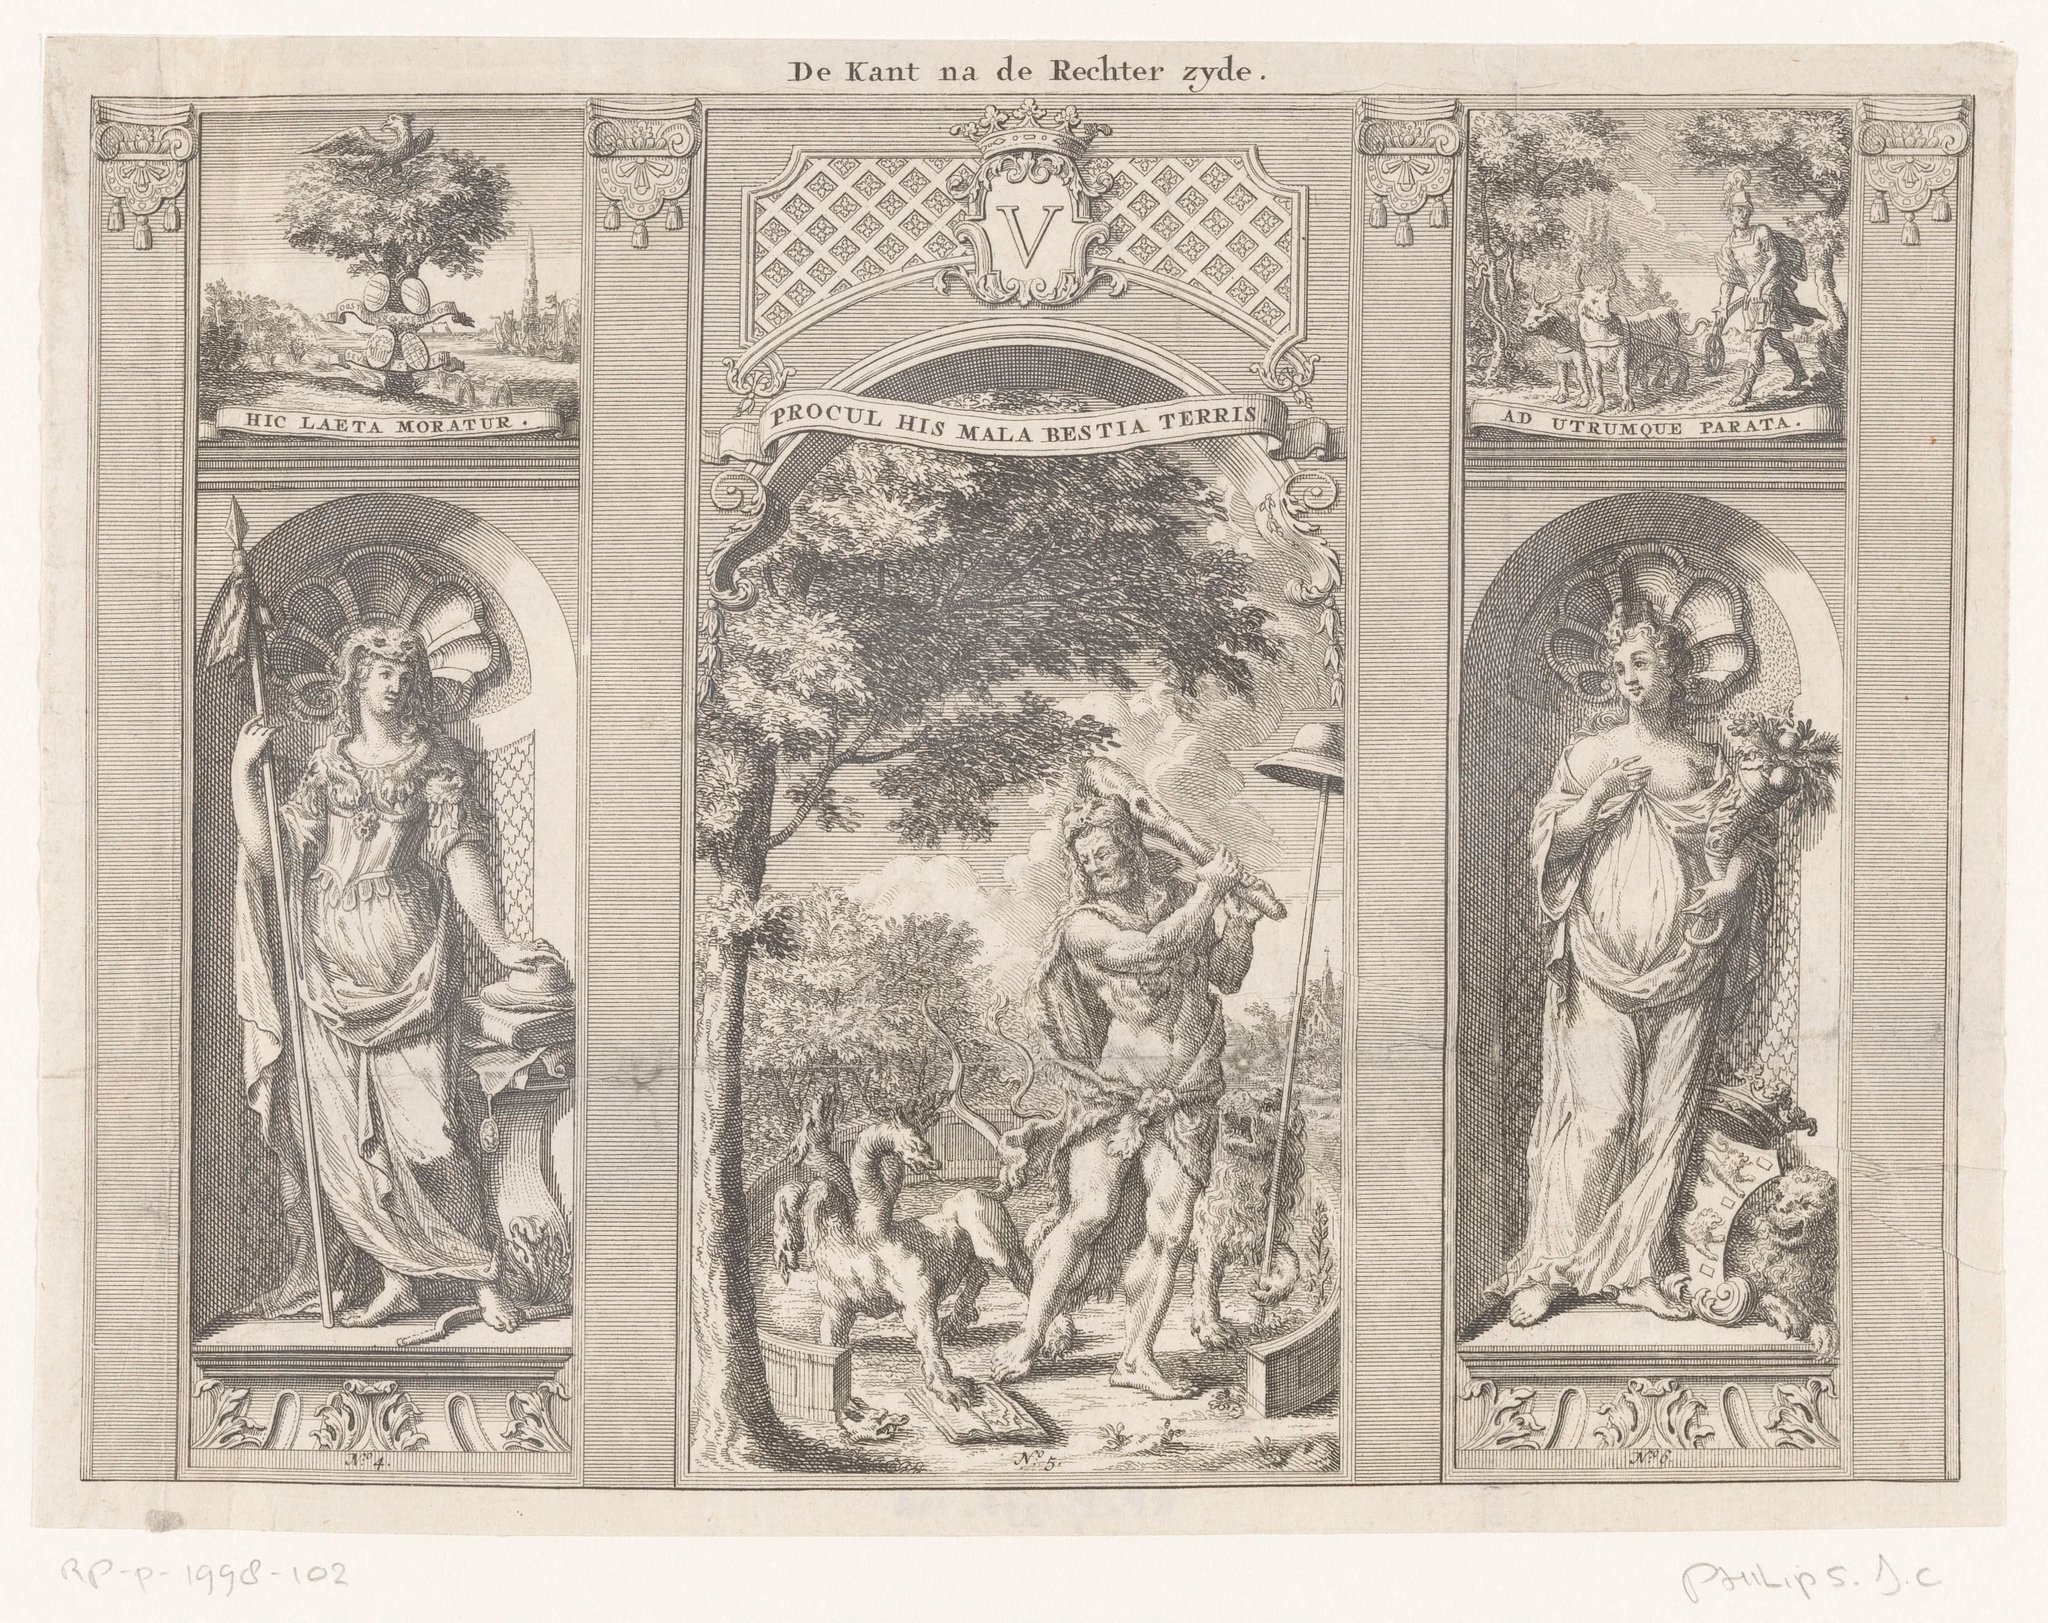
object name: ornament print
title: Personificaties van de Vrijheid en Friesland en Hercules verdrijft Hydra uit een tuin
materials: paper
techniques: engraving, etching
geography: leeuwarden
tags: the hague, willem iv (prins van oranje-nassau), anna van hannover, public festivities at marriage of royal persons (+ illumination, fire-works ~ festive activities)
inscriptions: collector's mark: Lugt 2228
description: De allegorische voorstellingen aangebracht op de rechterzijde van een tempel die 11 mei 1734 te Leeuwarden temidden van aangestoken vuurwerk stond ter gelegenheid van de inkomst van het pasgetrouwde paar prins Willem IV en prinses Anna, gehuwd op 25 maart 1734. Links boven een eik met wapens van de vier kwartieren van Friesland, daaronder een personificatie van de Vrijheid (No 4), in het midden verdrijft Hercules het monster Hydra uit de Nederlandse tuin (No 5), rechts boven Jason met een ploeg en rechts onder een personificatie van Friesland met een muurkroon en de hoorn des overvloeds (No 5).